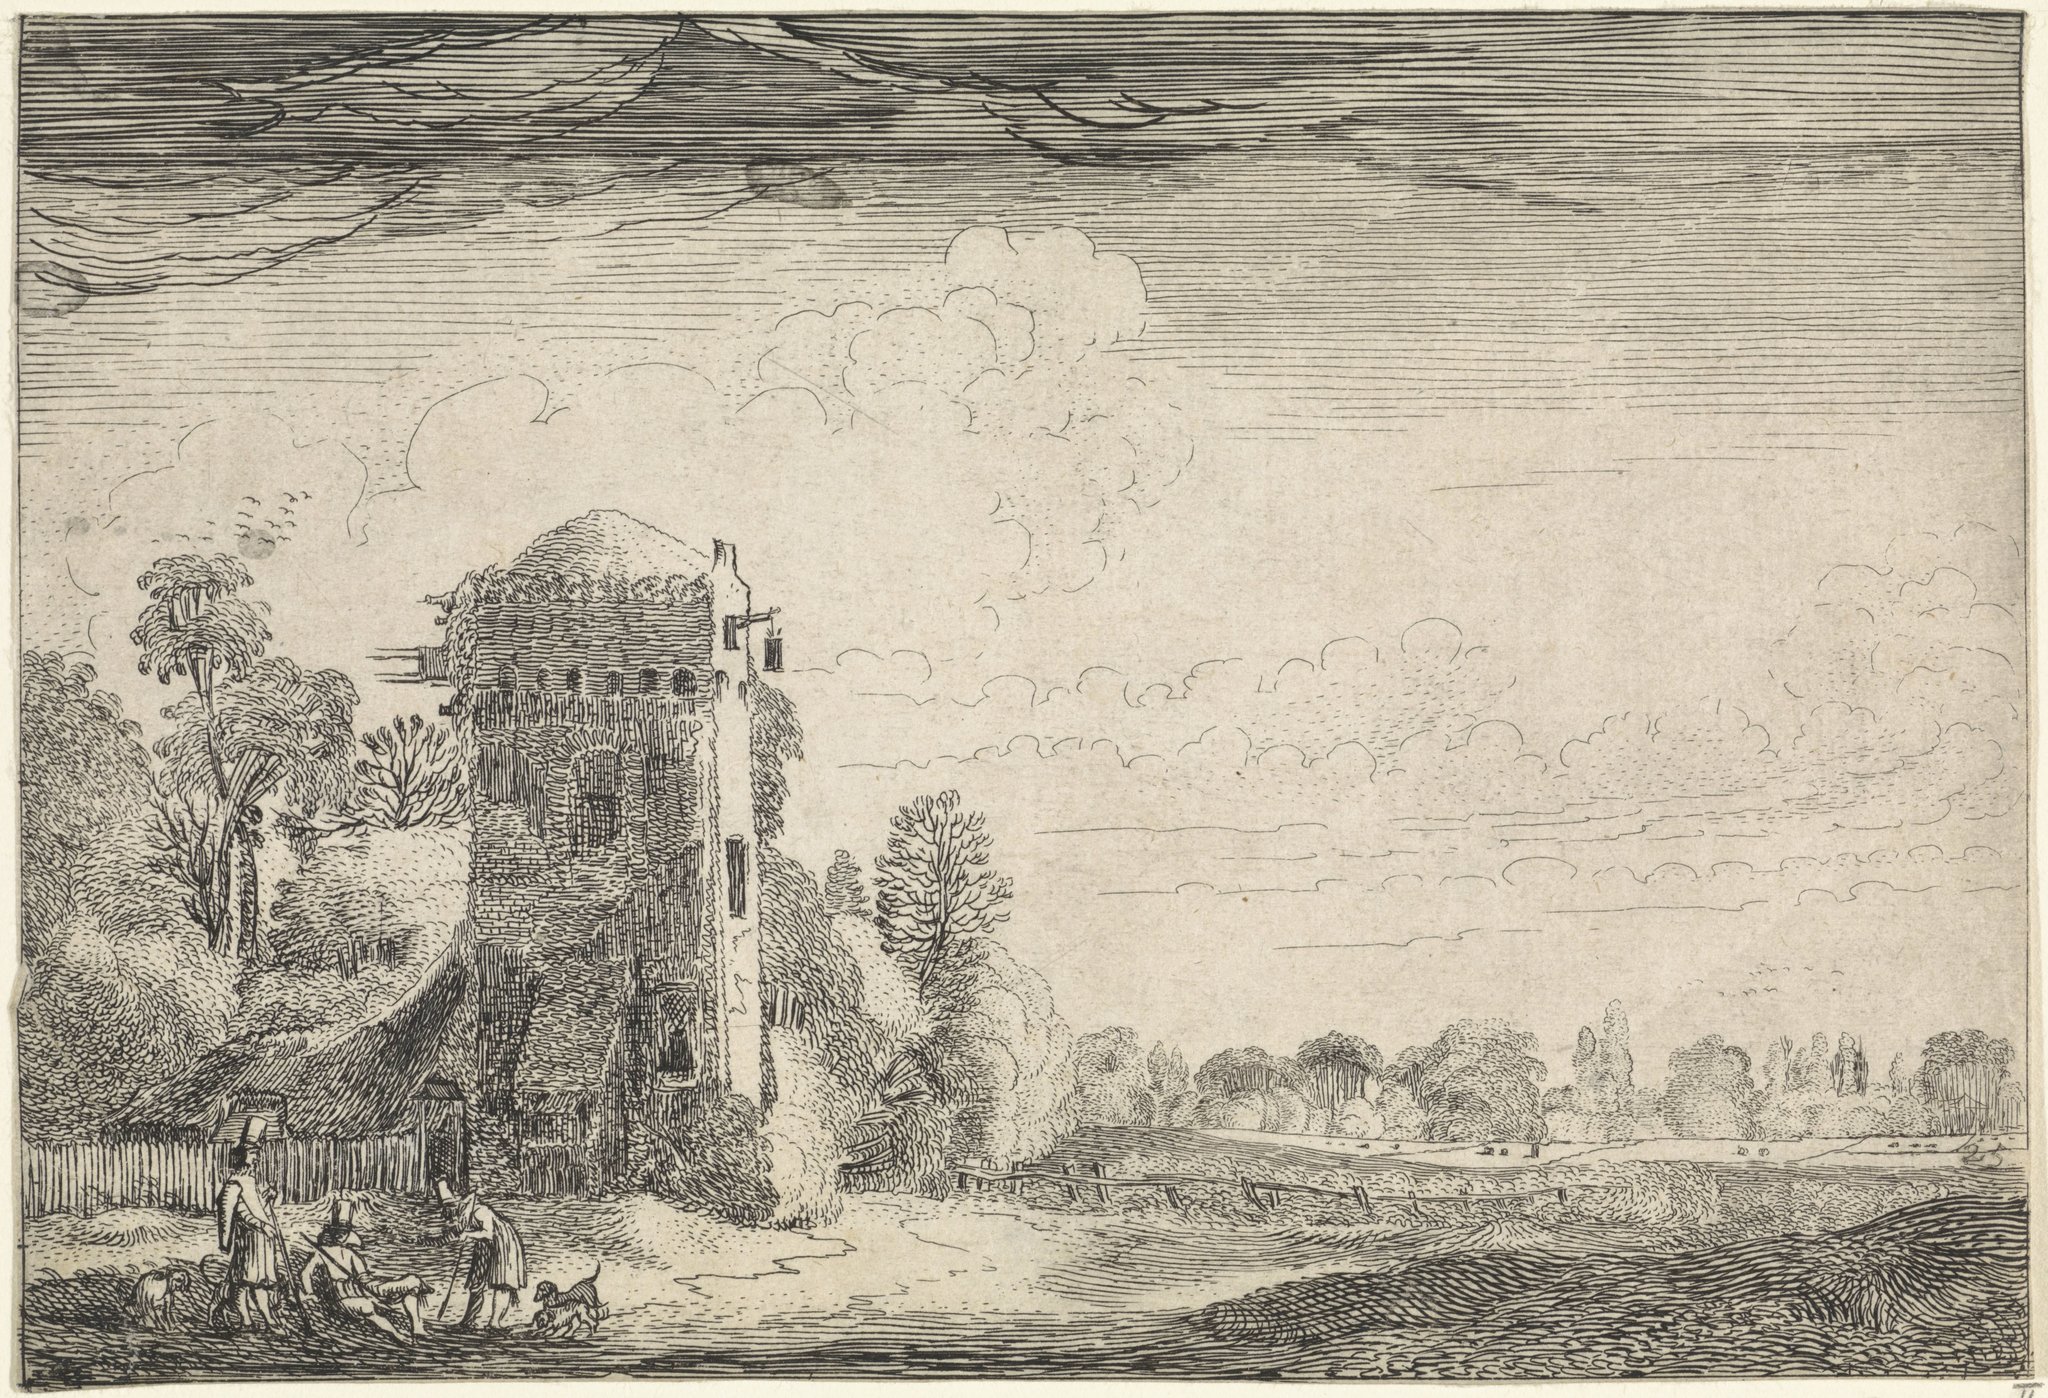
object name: print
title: Amenissimae aliquot requculae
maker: jan van de velde (ii)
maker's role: draughtsman, painter, print maker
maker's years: 1593-1641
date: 1616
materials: paper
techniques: etching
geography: northern netherlands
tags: hunter, landscape with tower or castle, parts of church exterior and annexes: tower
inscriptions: collector's mark: Lugt 2228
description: Drie jagers met hun honden bij een vierkante toren in een landschap. Vijfentwintigste prent van een serie van in totaal 52 prenten met landschappen, verdeeld over twee delen van elk 26 prenten.